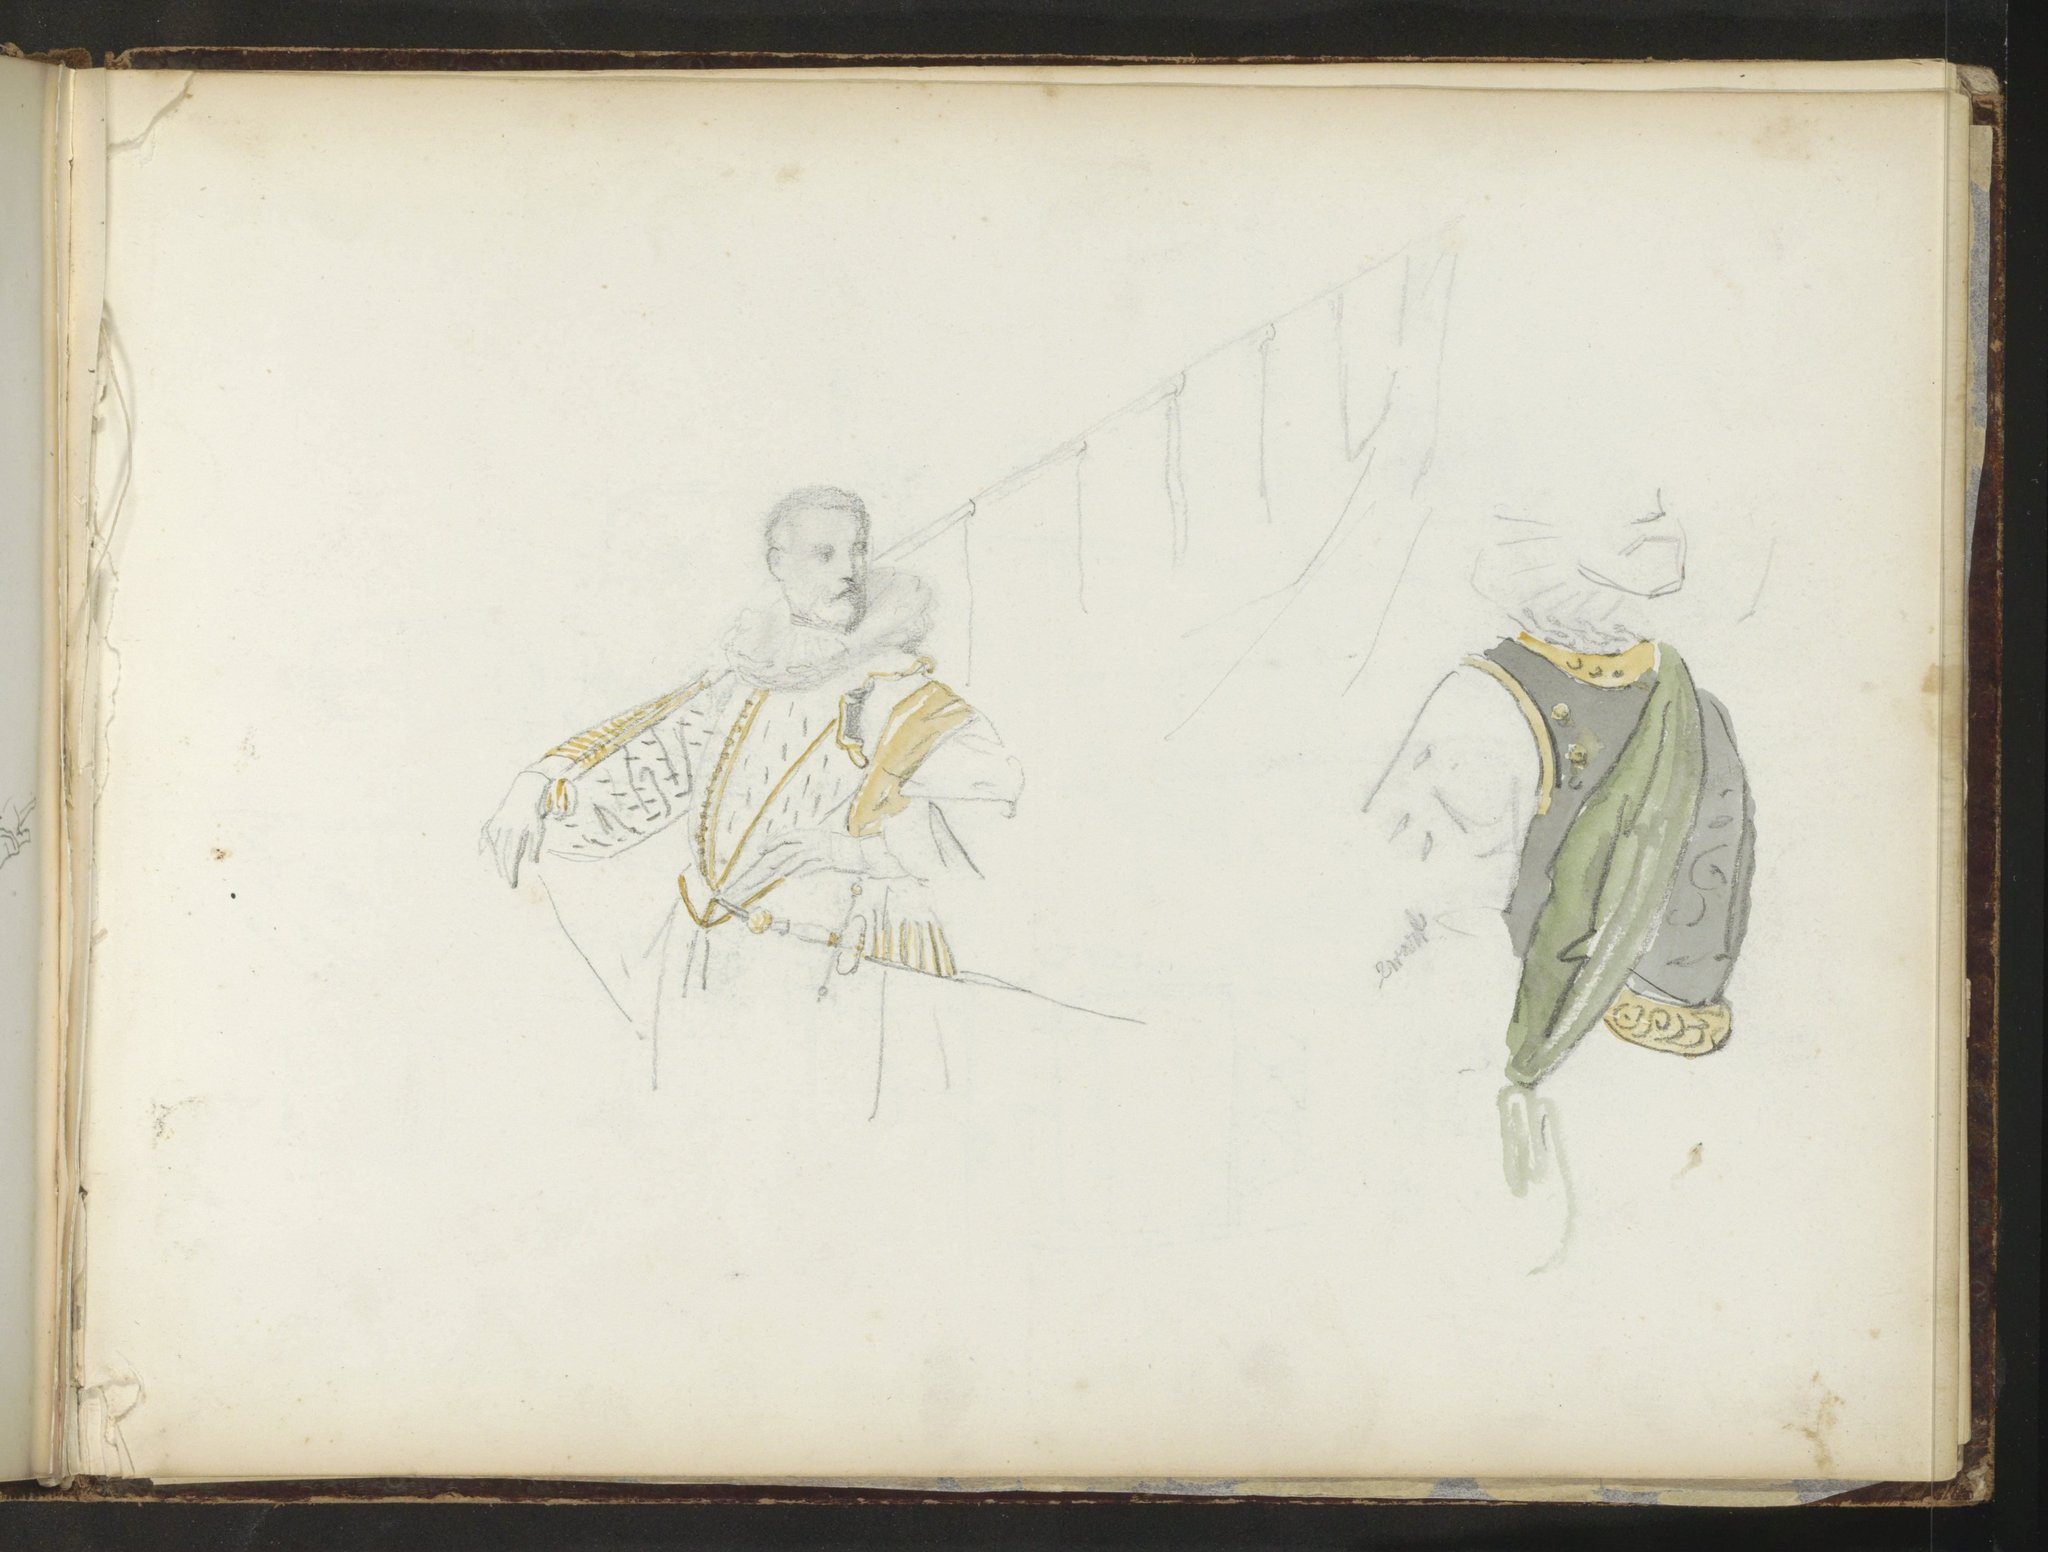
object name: sketchbook leaf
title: Vaandeldrager en een man in een harnas met sjerp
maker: reinier craeyvanger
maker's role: draughtsman, print maker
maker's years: 1812-1880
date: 1822-1880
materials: paper, pencil, watercolor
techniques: brush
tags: standard-bearer, flag-bearer, harness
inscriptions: kleurnotitie, handgeschreven in potlood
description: Mogelijk naar prenten getekend. Blad 33 recto uit een schetsboek met 45 bladen.